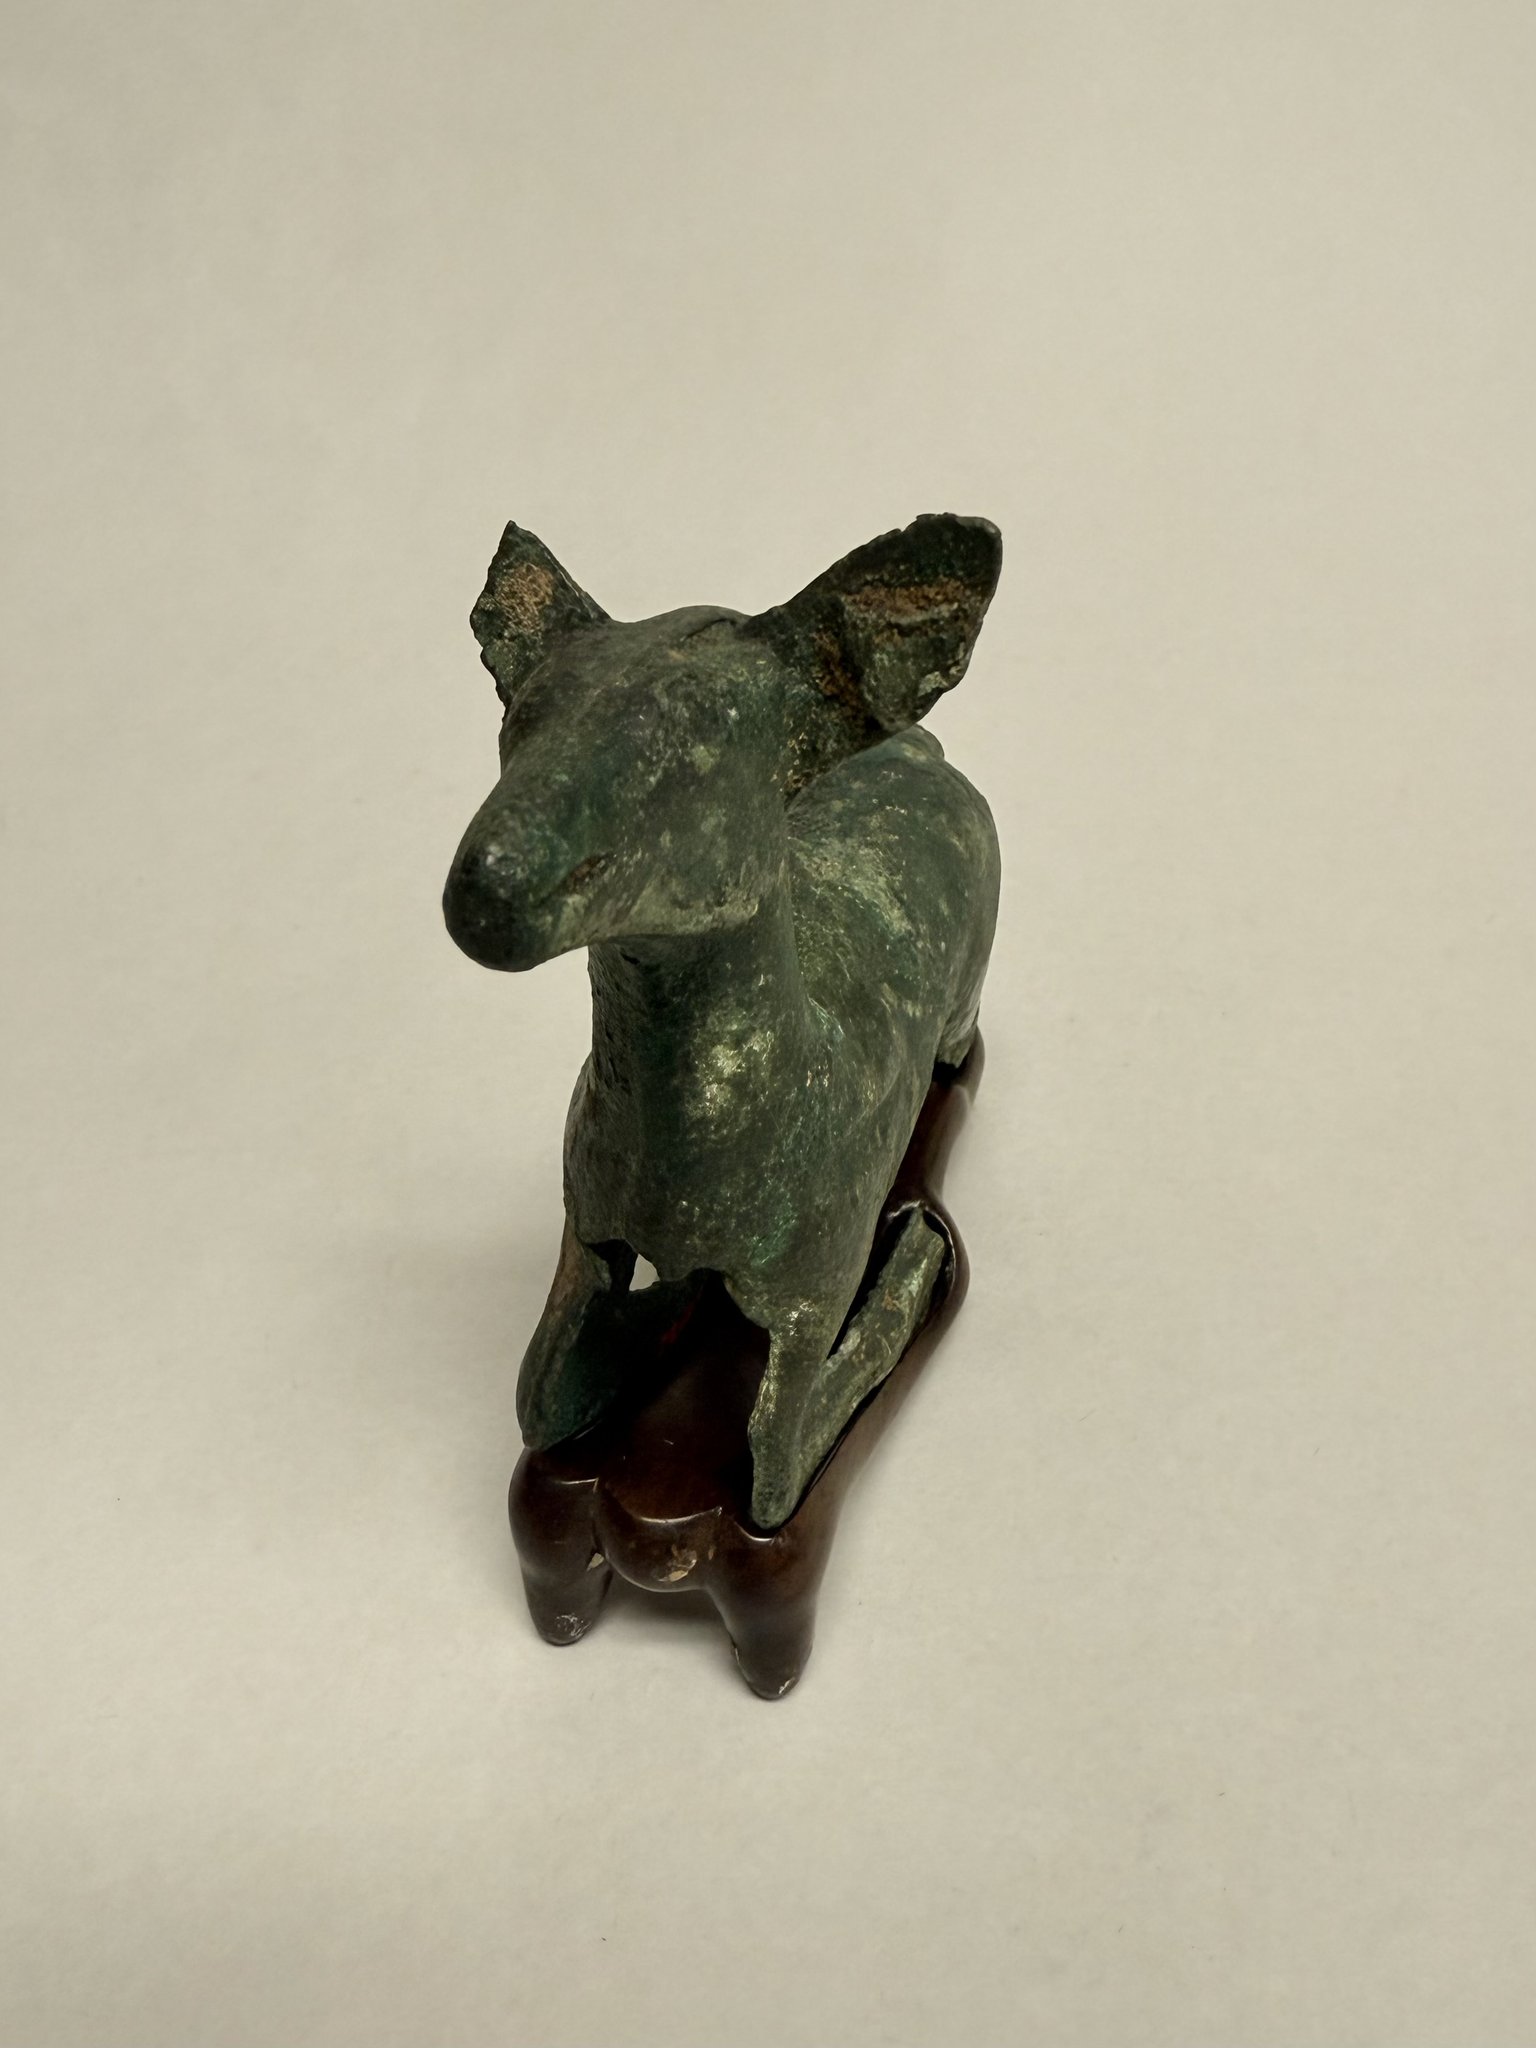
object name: yoke ornament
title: Yoke ornament in the shape of a deer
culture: chinese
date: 500-301 BCE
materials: bronze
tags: deer